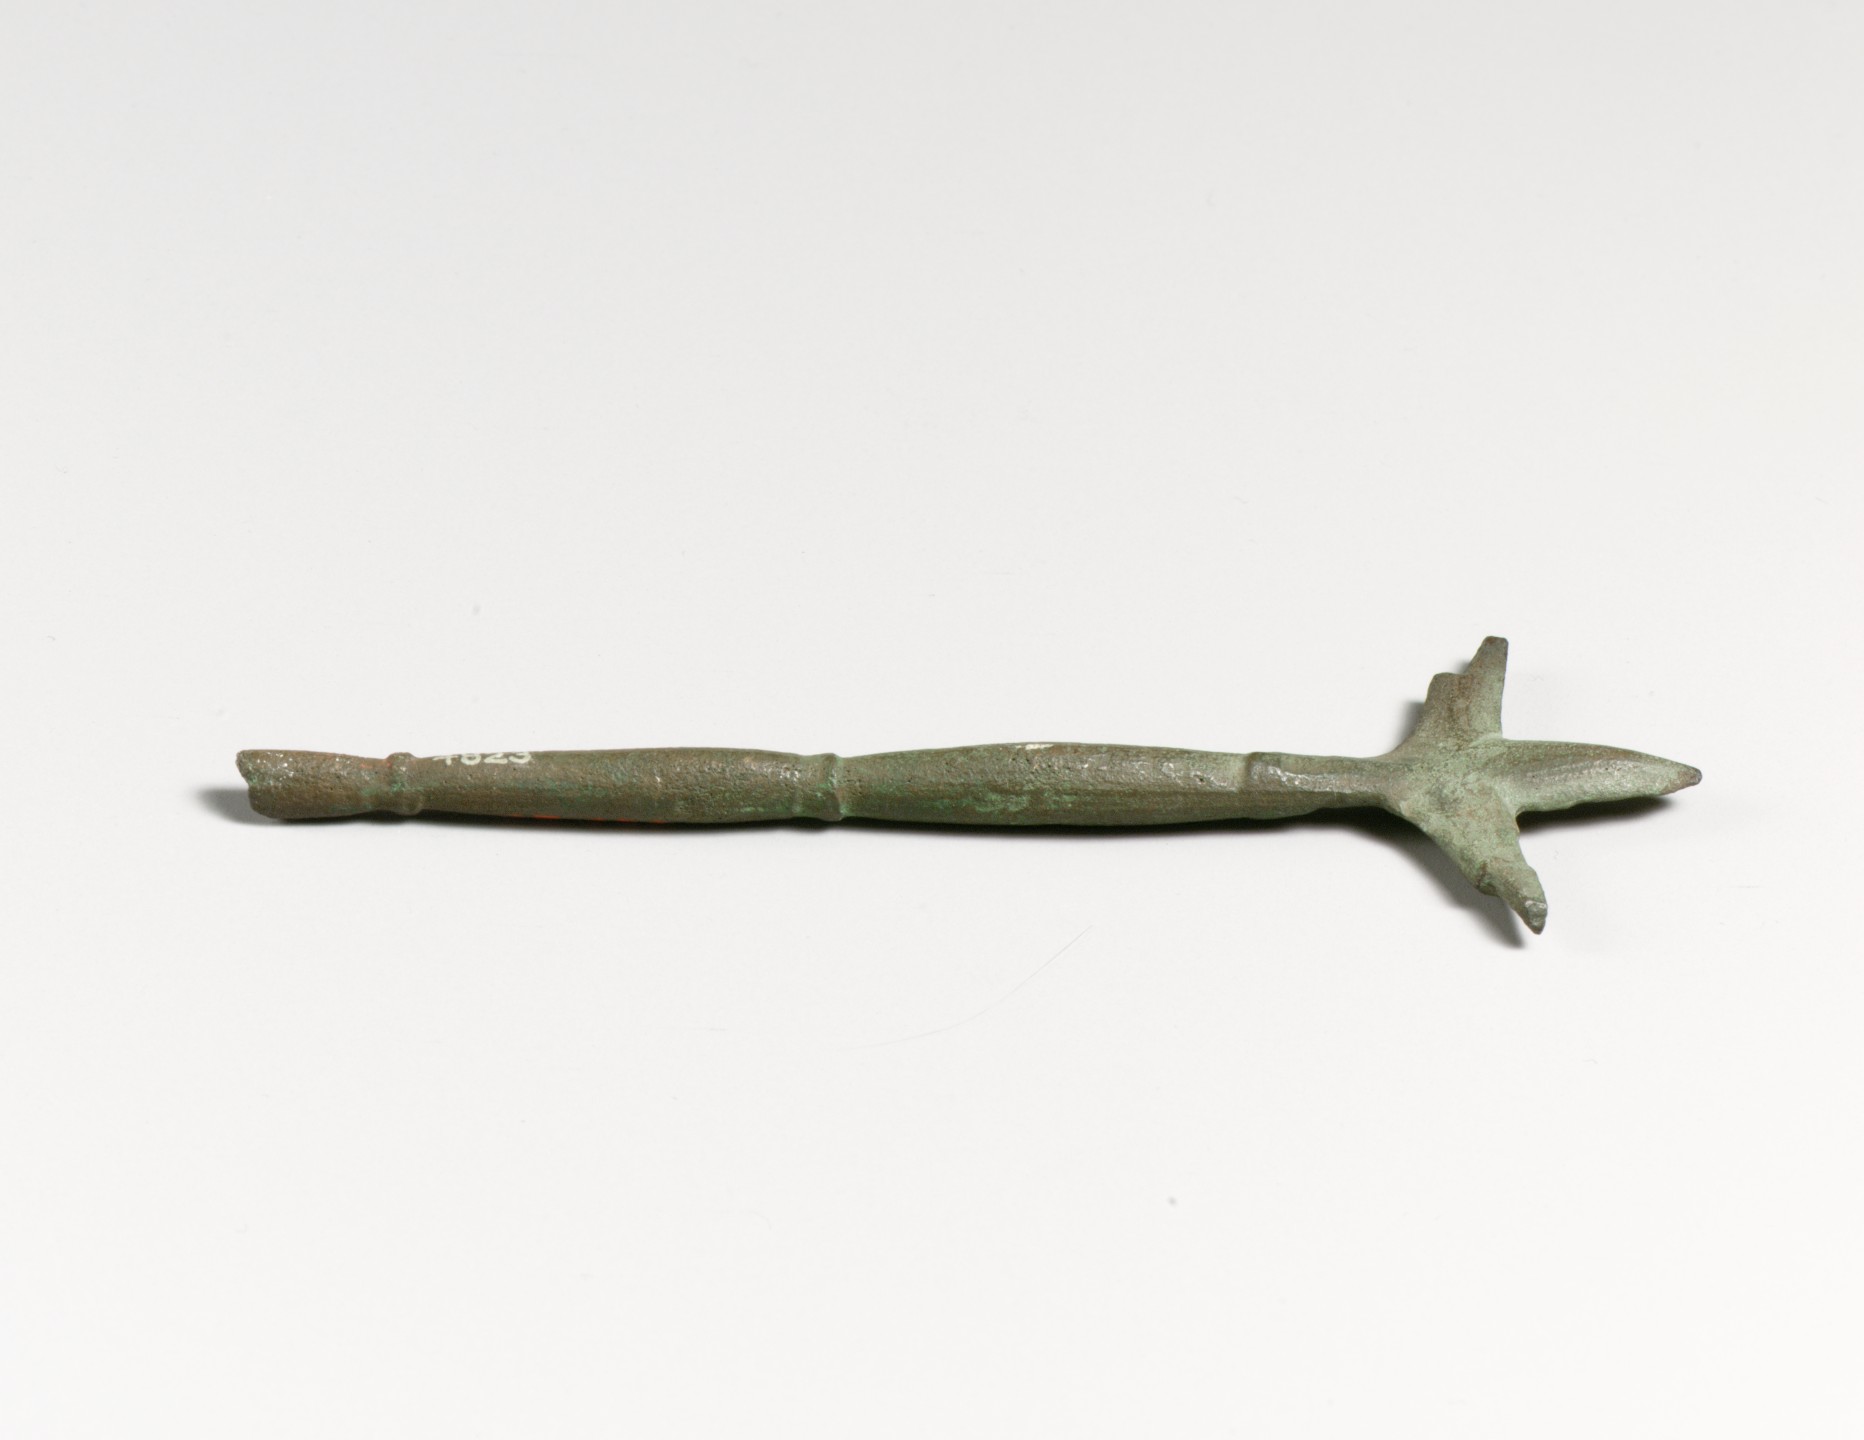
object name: mirror handle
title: Handle of a mirror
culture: roman, cypriot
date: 50-400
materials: bronze